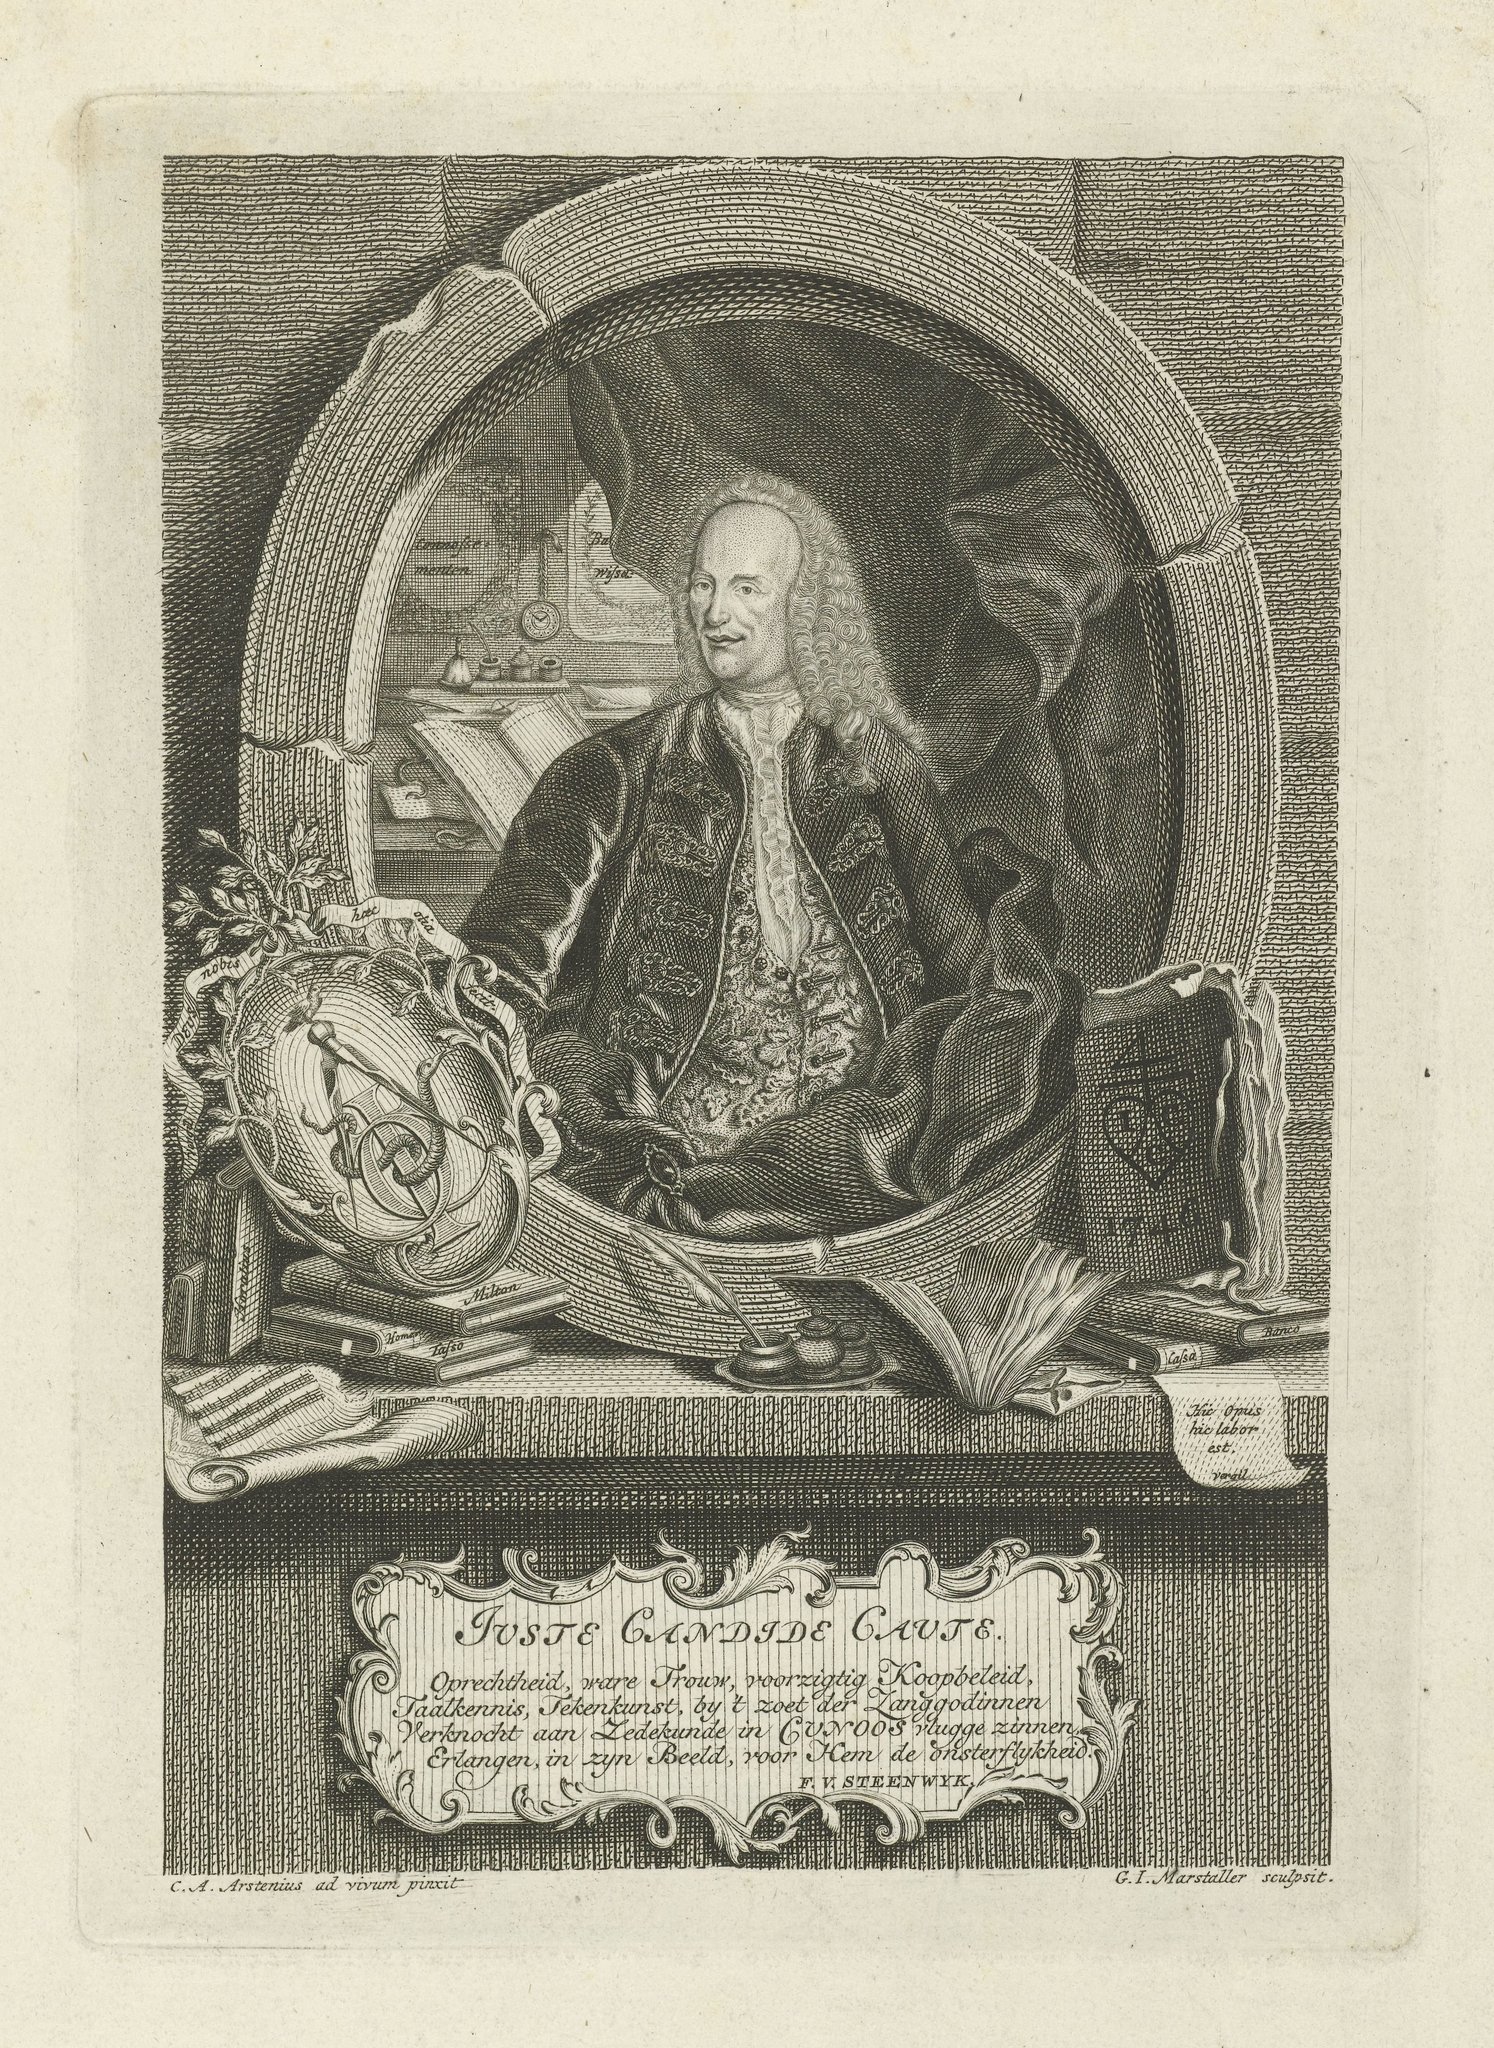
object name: print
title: Portret van Johann Christian Cuno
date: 1746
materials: paper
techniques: engraving, etching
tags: berlin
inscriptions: collector's mark: Lugt 2228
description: Portret van de schrijver en koopman Johann Christian Cuno.